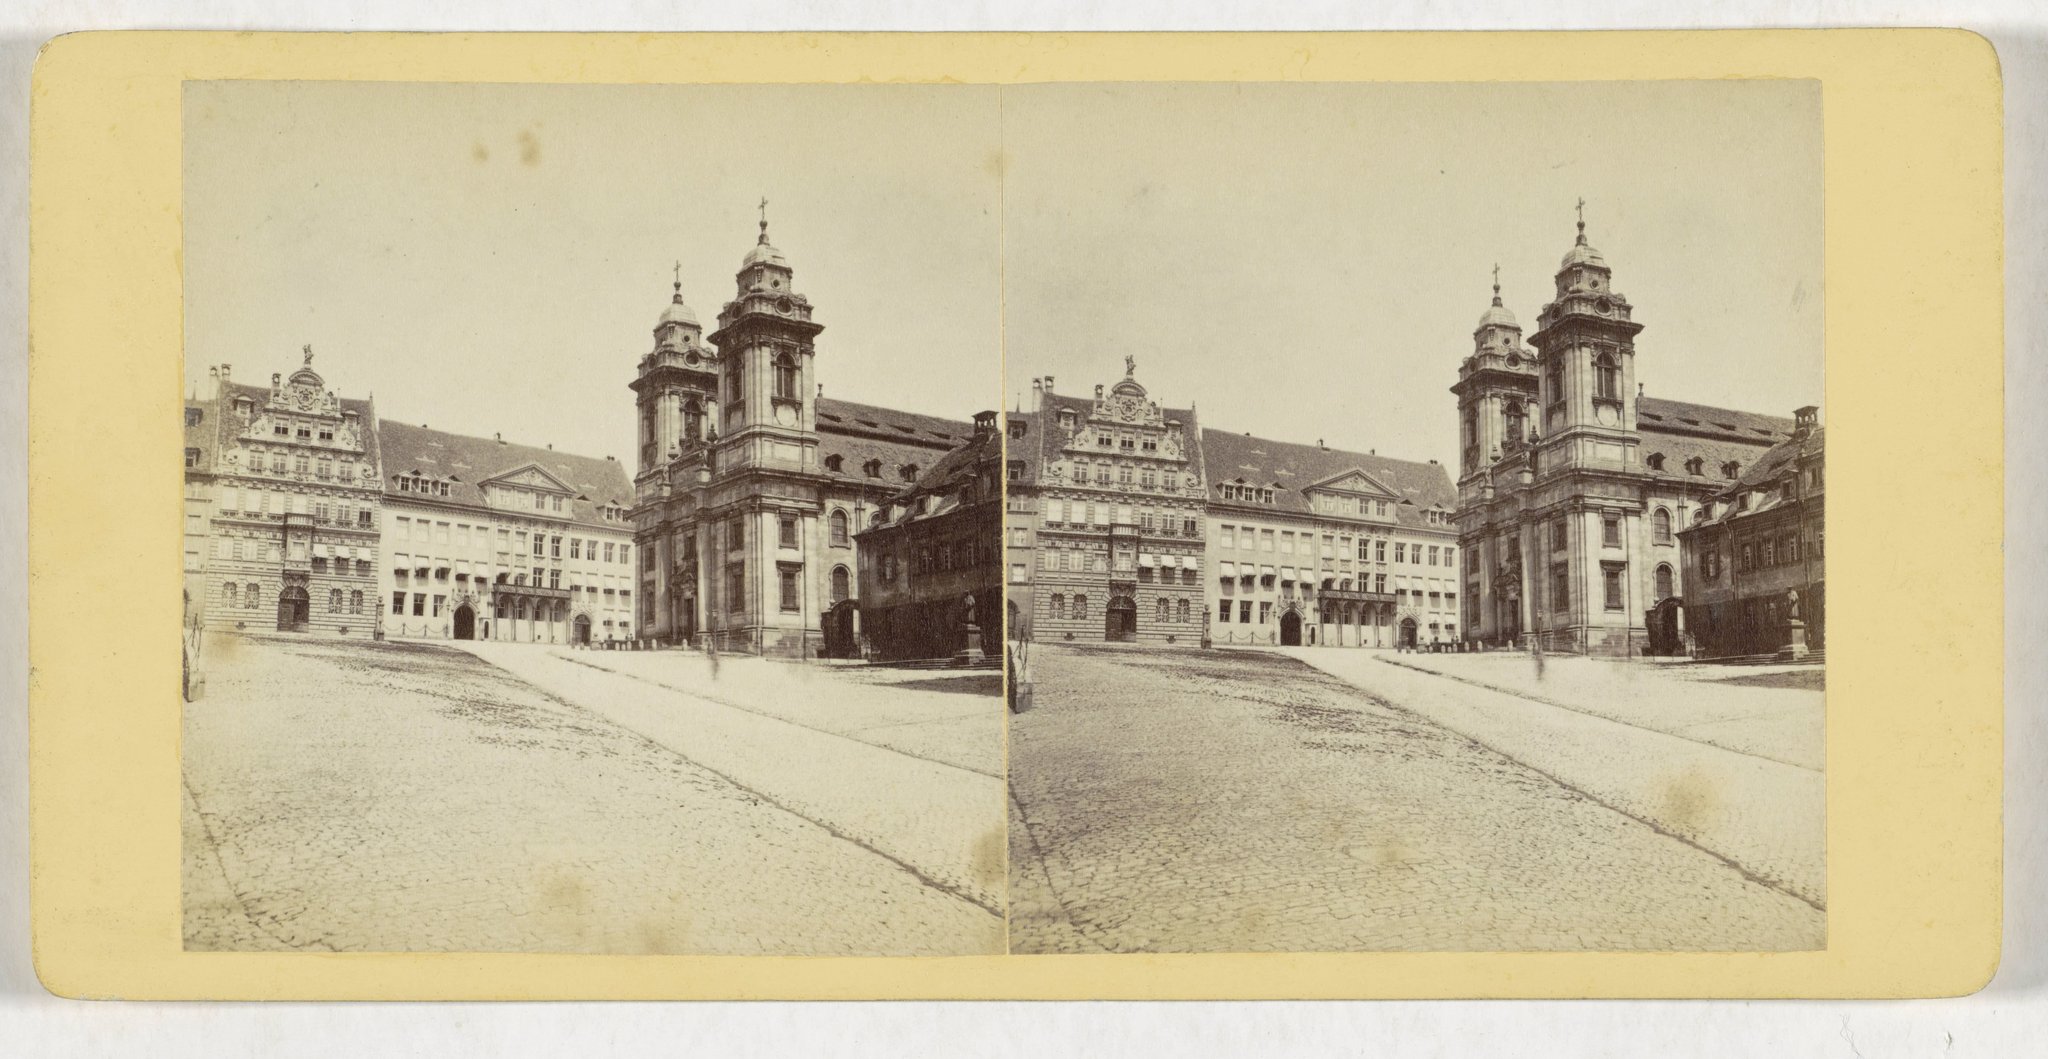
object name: stereograph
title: Deutschland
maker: johann friedrich stiehm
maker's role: fotograaf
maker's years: 1826-1902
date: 1868-1888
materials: cardboard, paper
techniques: albumen print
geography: london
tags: square, place, circus, etc., church (exterior)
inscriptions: number: ‘No. 9.’